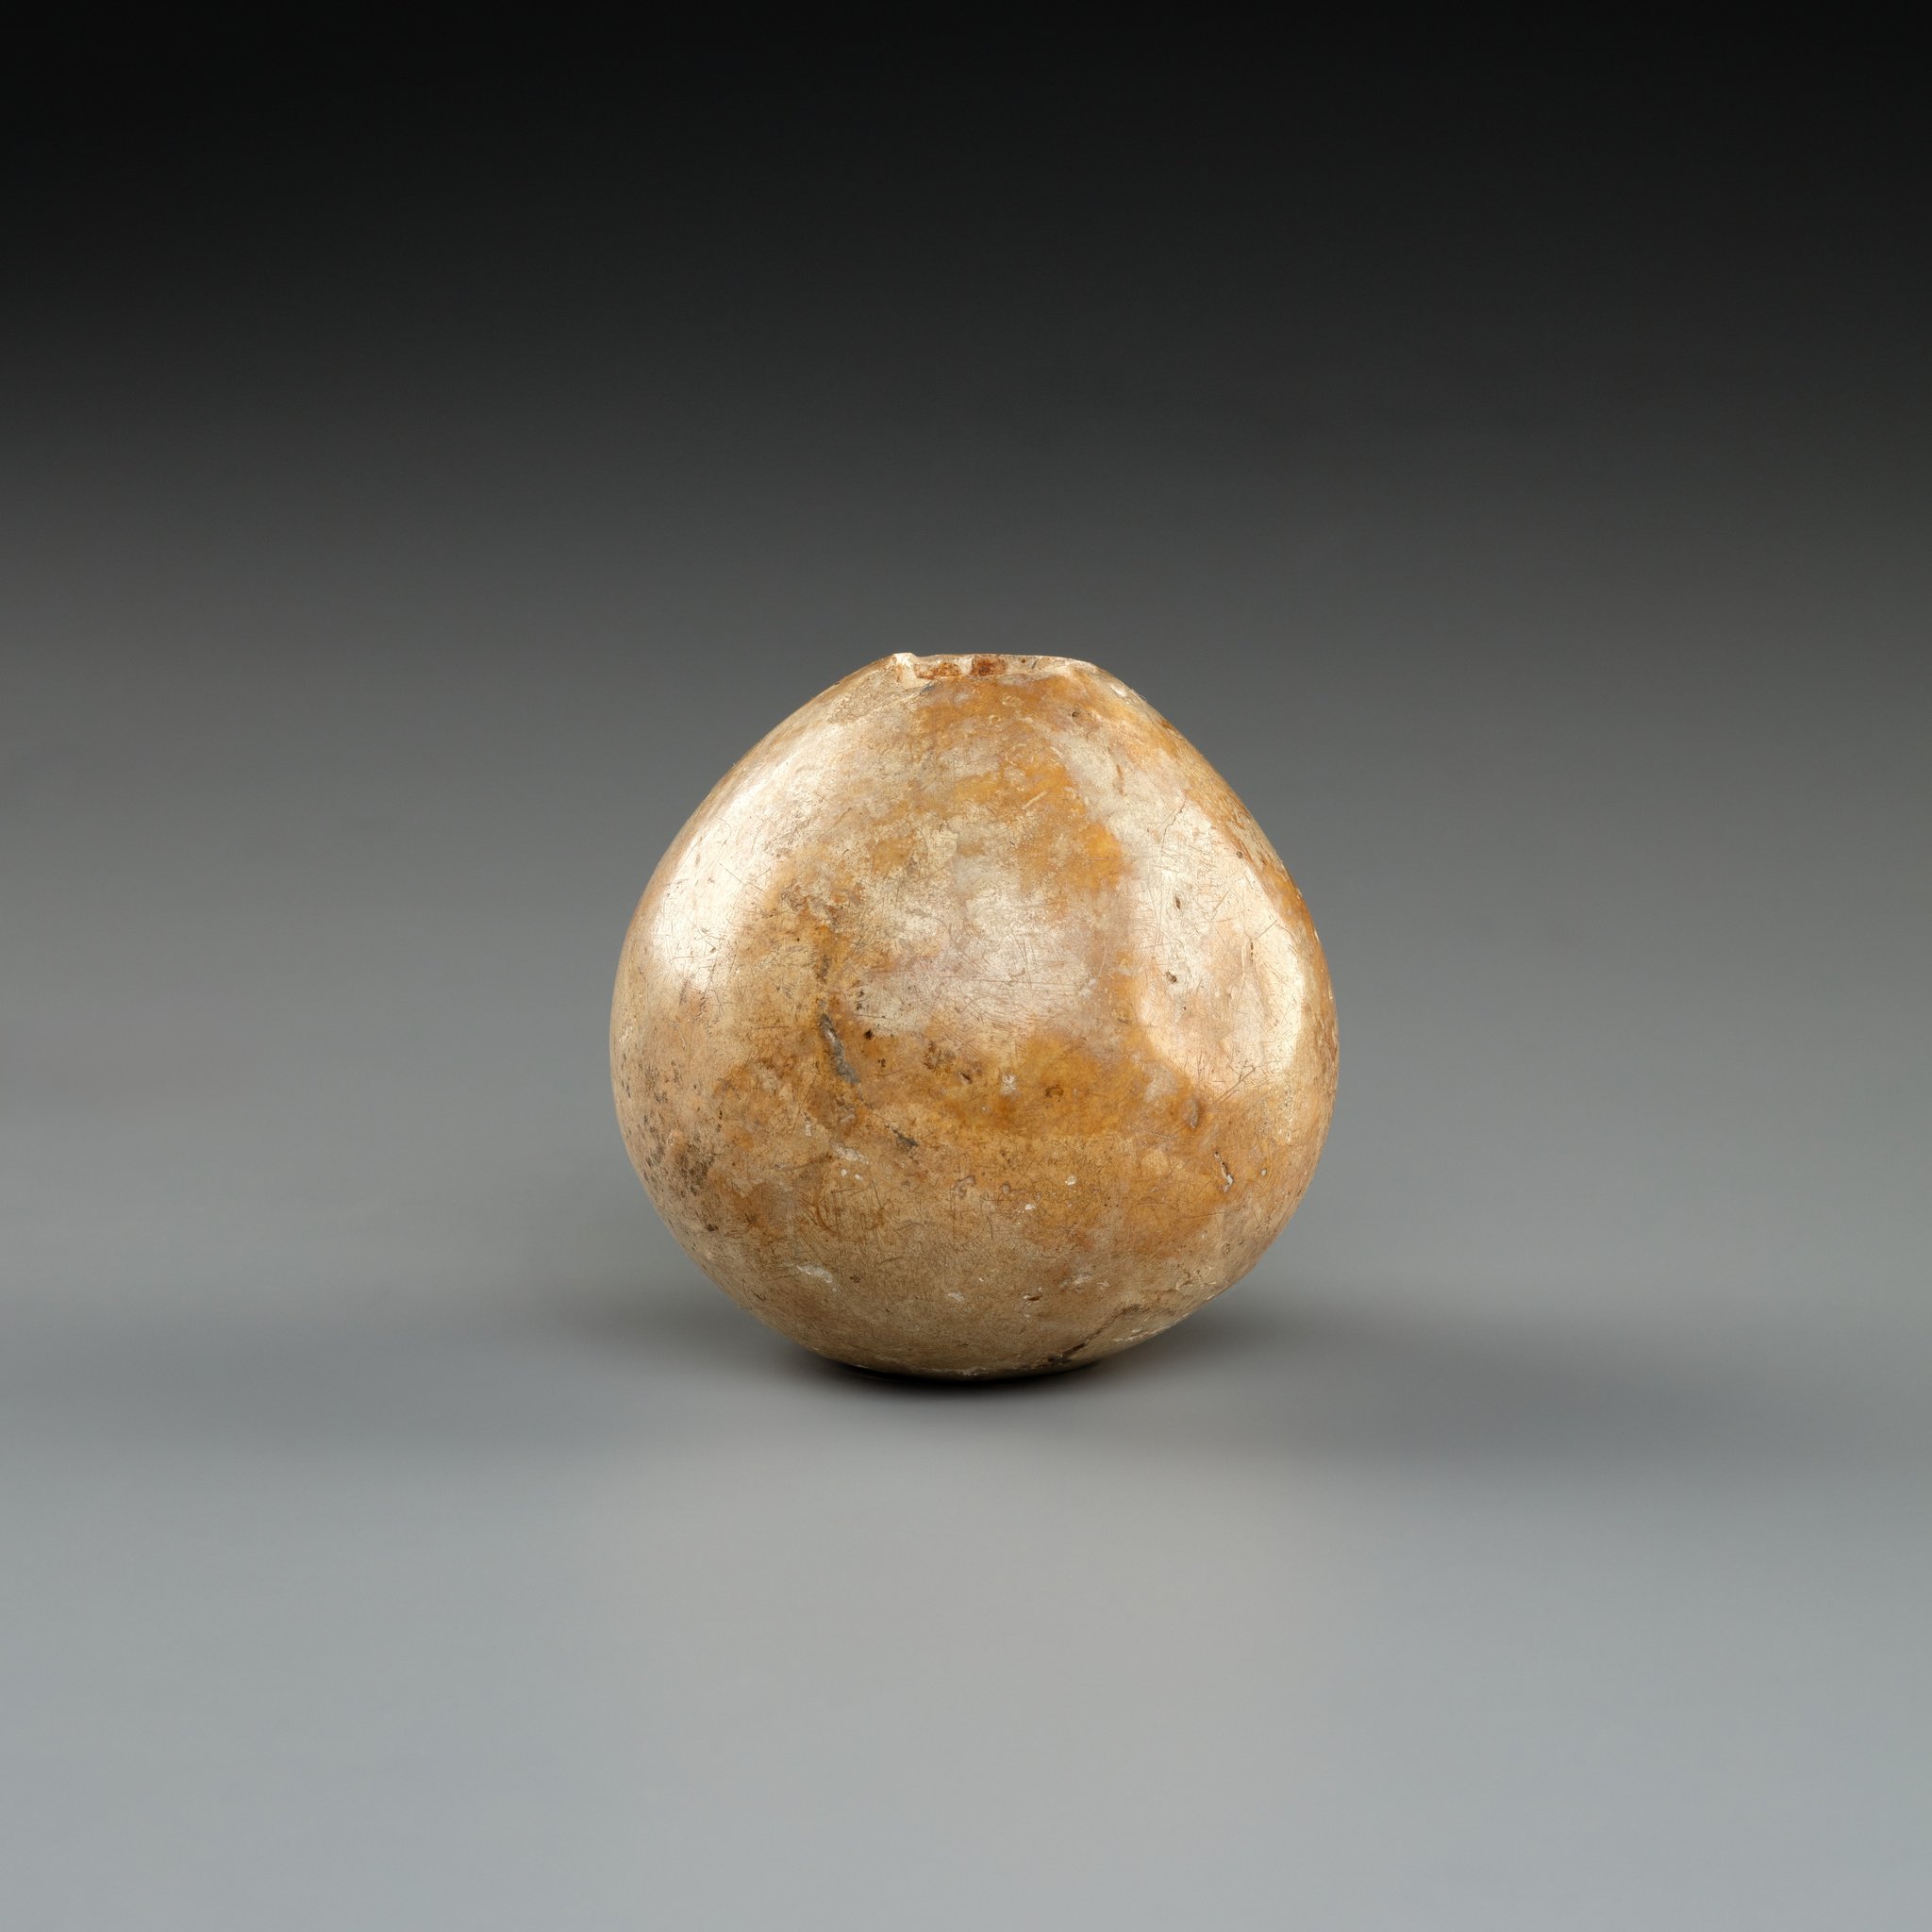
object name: mace head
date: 3850-2960 BCE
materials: stone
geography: egypt